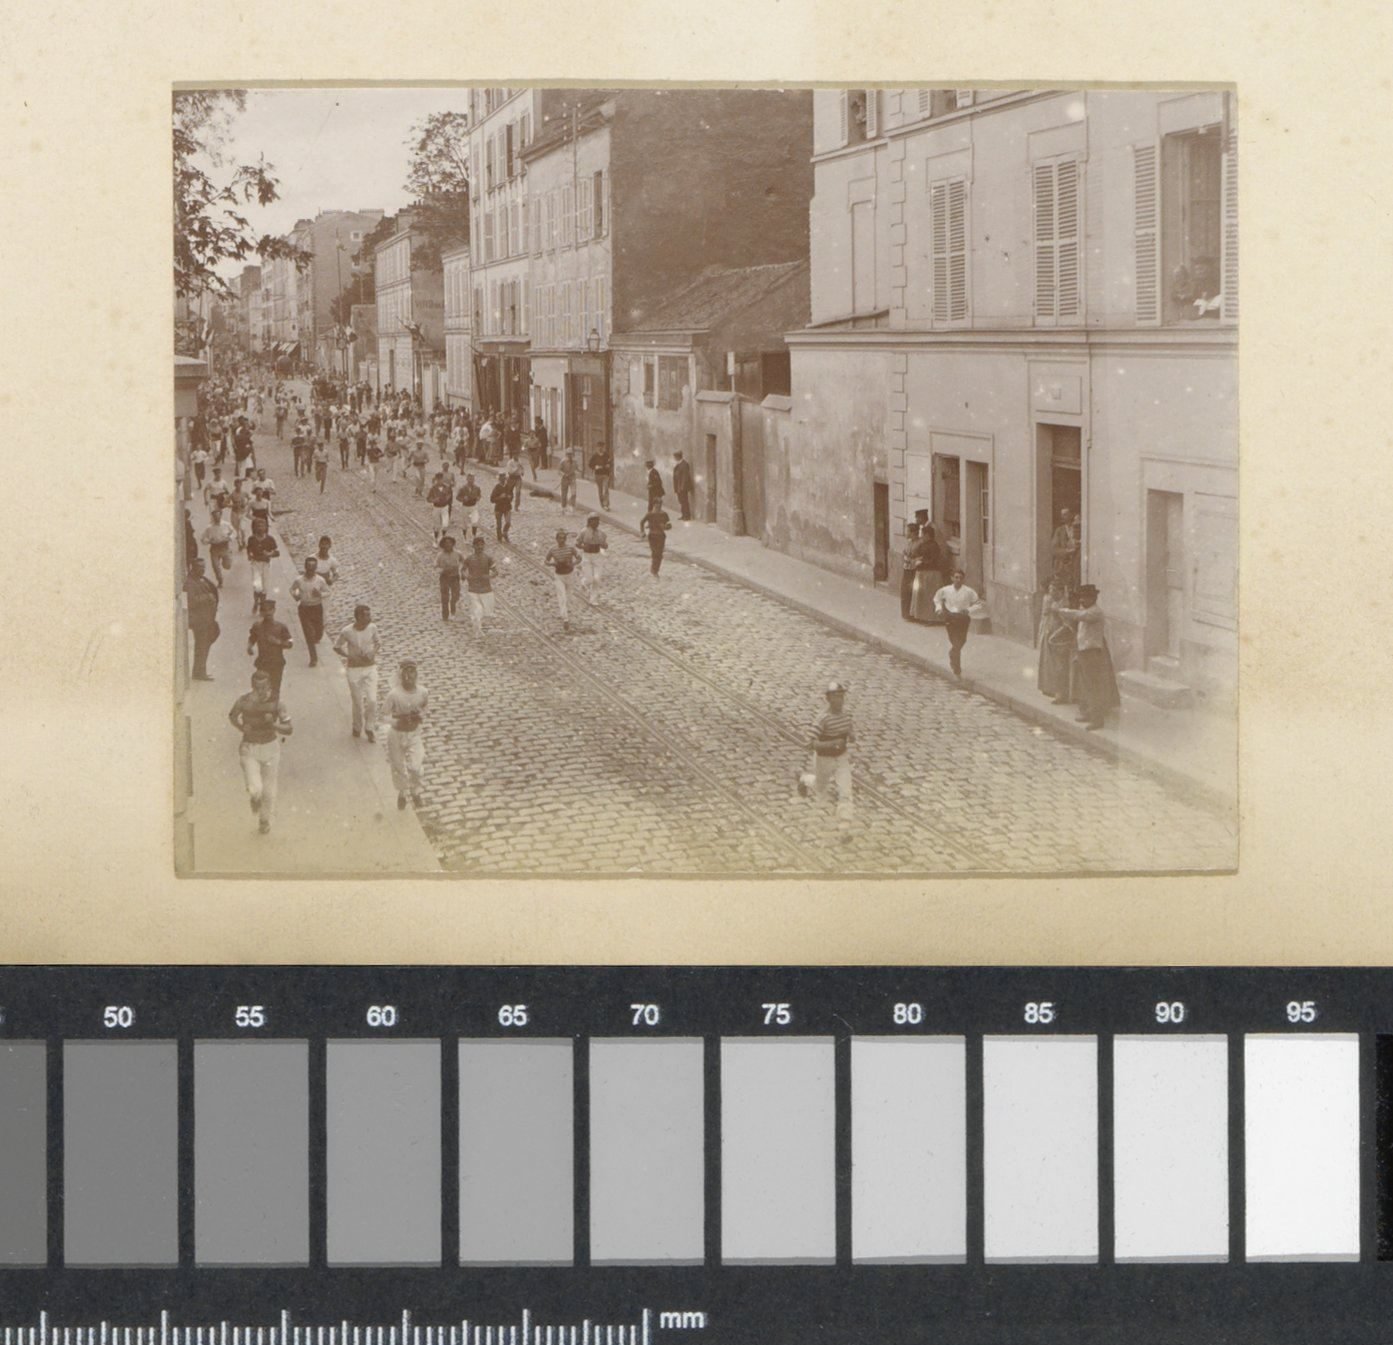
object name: photograph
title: Rennende jongeren in een straat in Frankrijk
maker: Anonymous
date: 1900-1910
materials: paper, photographic support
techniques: daylight paper print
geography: france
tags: running (~ game), street (+ city(-scape) with figures, staffage), france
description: Onderdeel van Fotoalbum van een Franse amateurfotograaf met opnames van een familie, distilleerderij Delizy & Doistau Fils, het leger en bezienswaardigheden in Frankrijk.